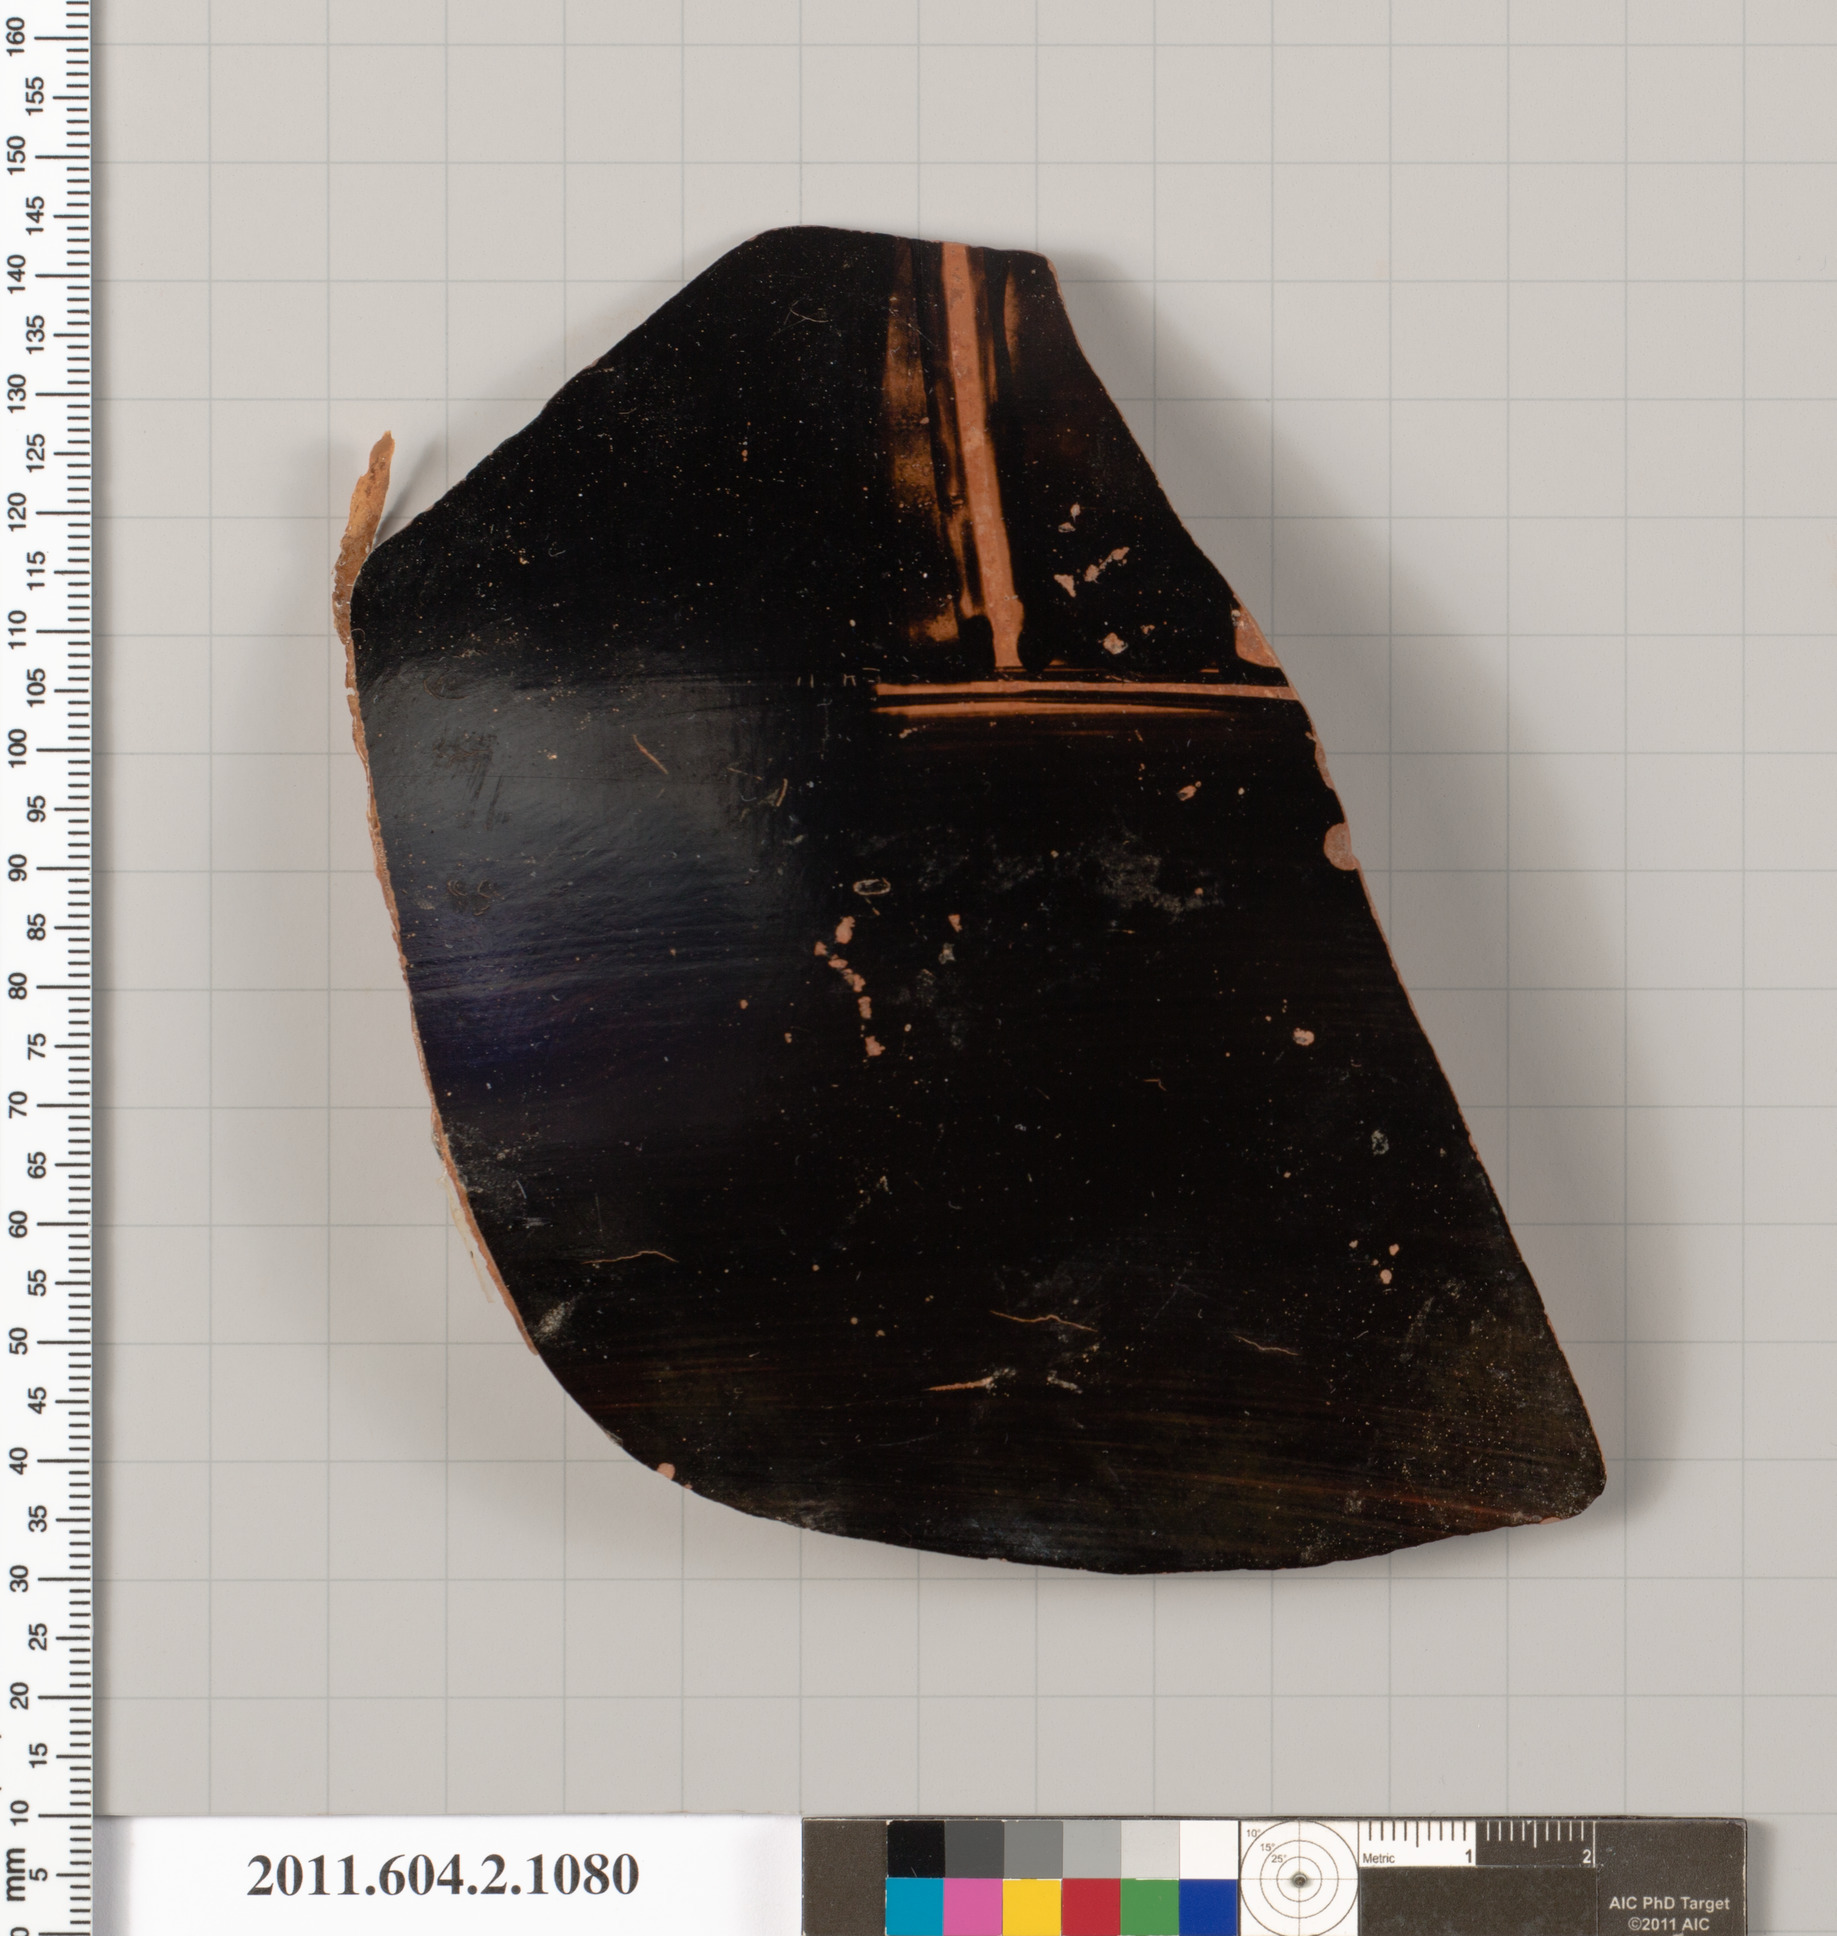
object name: hydria fragment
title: Terracotta fragment of a hydria (water jar)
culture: greek, attic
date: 500-476 BCE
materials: terracotta